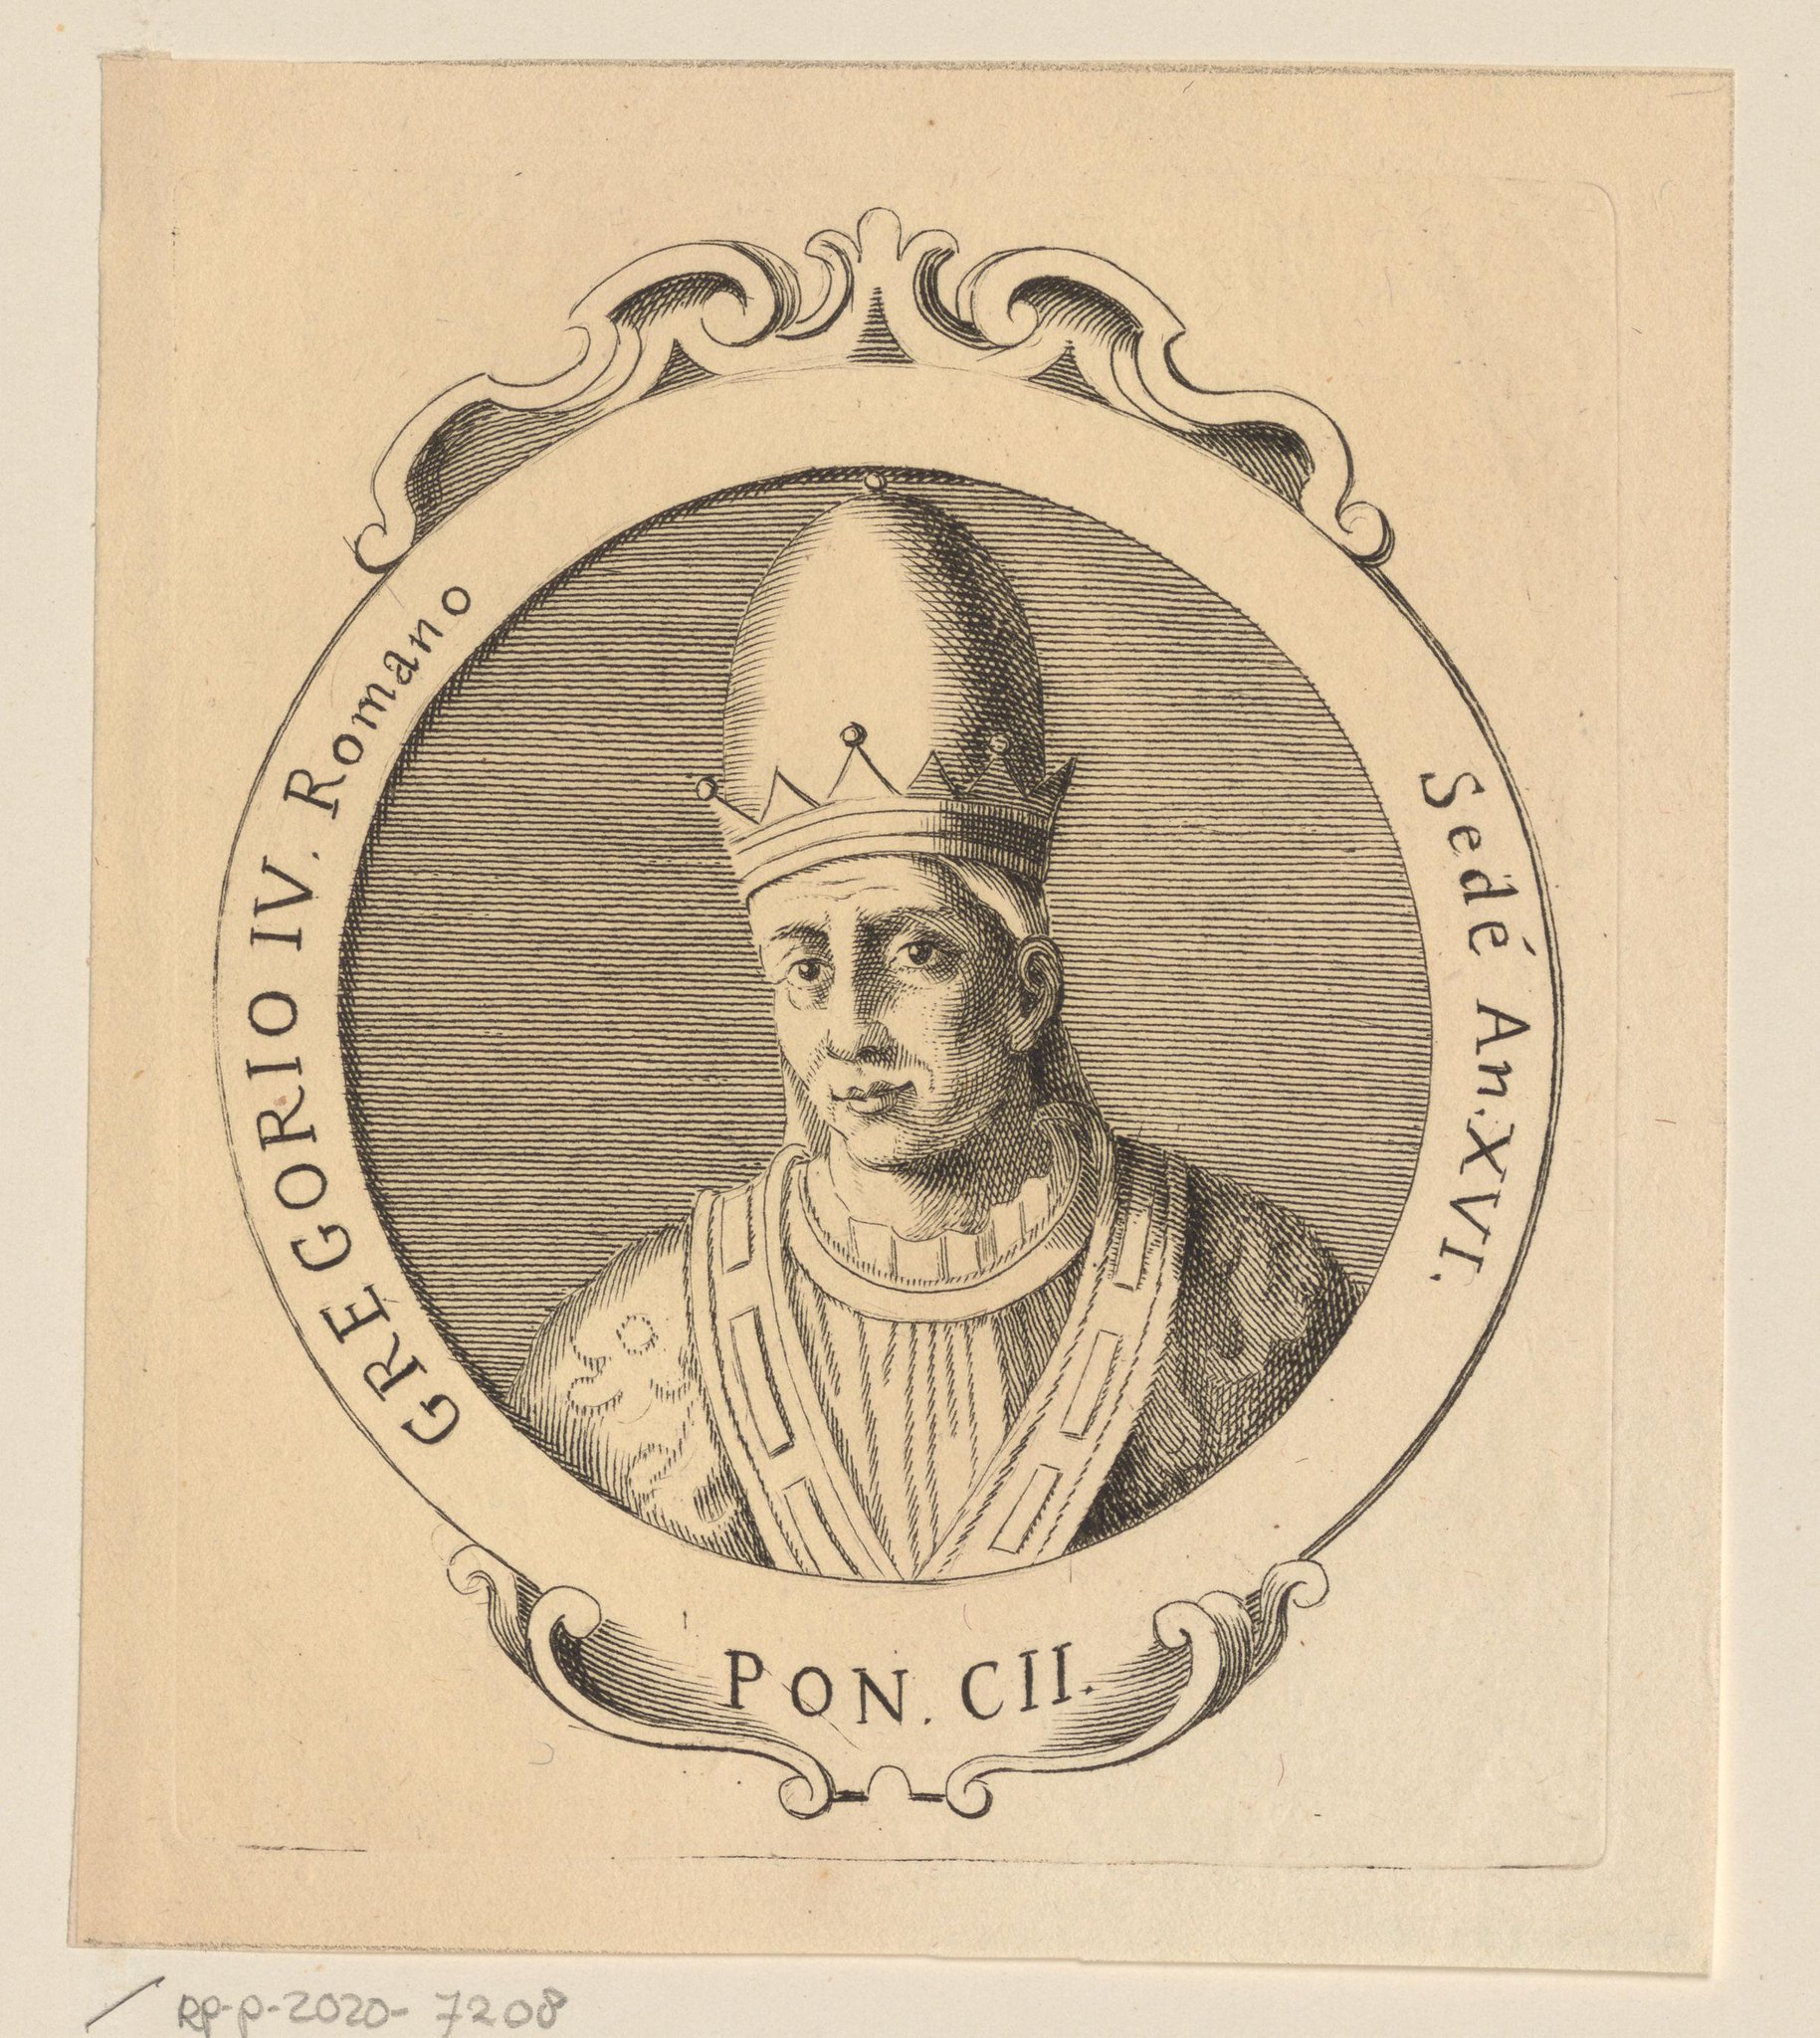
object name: print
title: Portret van paus Gregorius IV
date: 1775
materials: paper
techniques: engraving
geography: venice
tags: historical persons, pope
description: Prent uit: Effigies Romanorum pontificum a S. Petro ad Pium VI. feliciter regnantem (...). 2 dln. Venetië en Bassano del Grappa: Giuseppe Remondini, 1775.